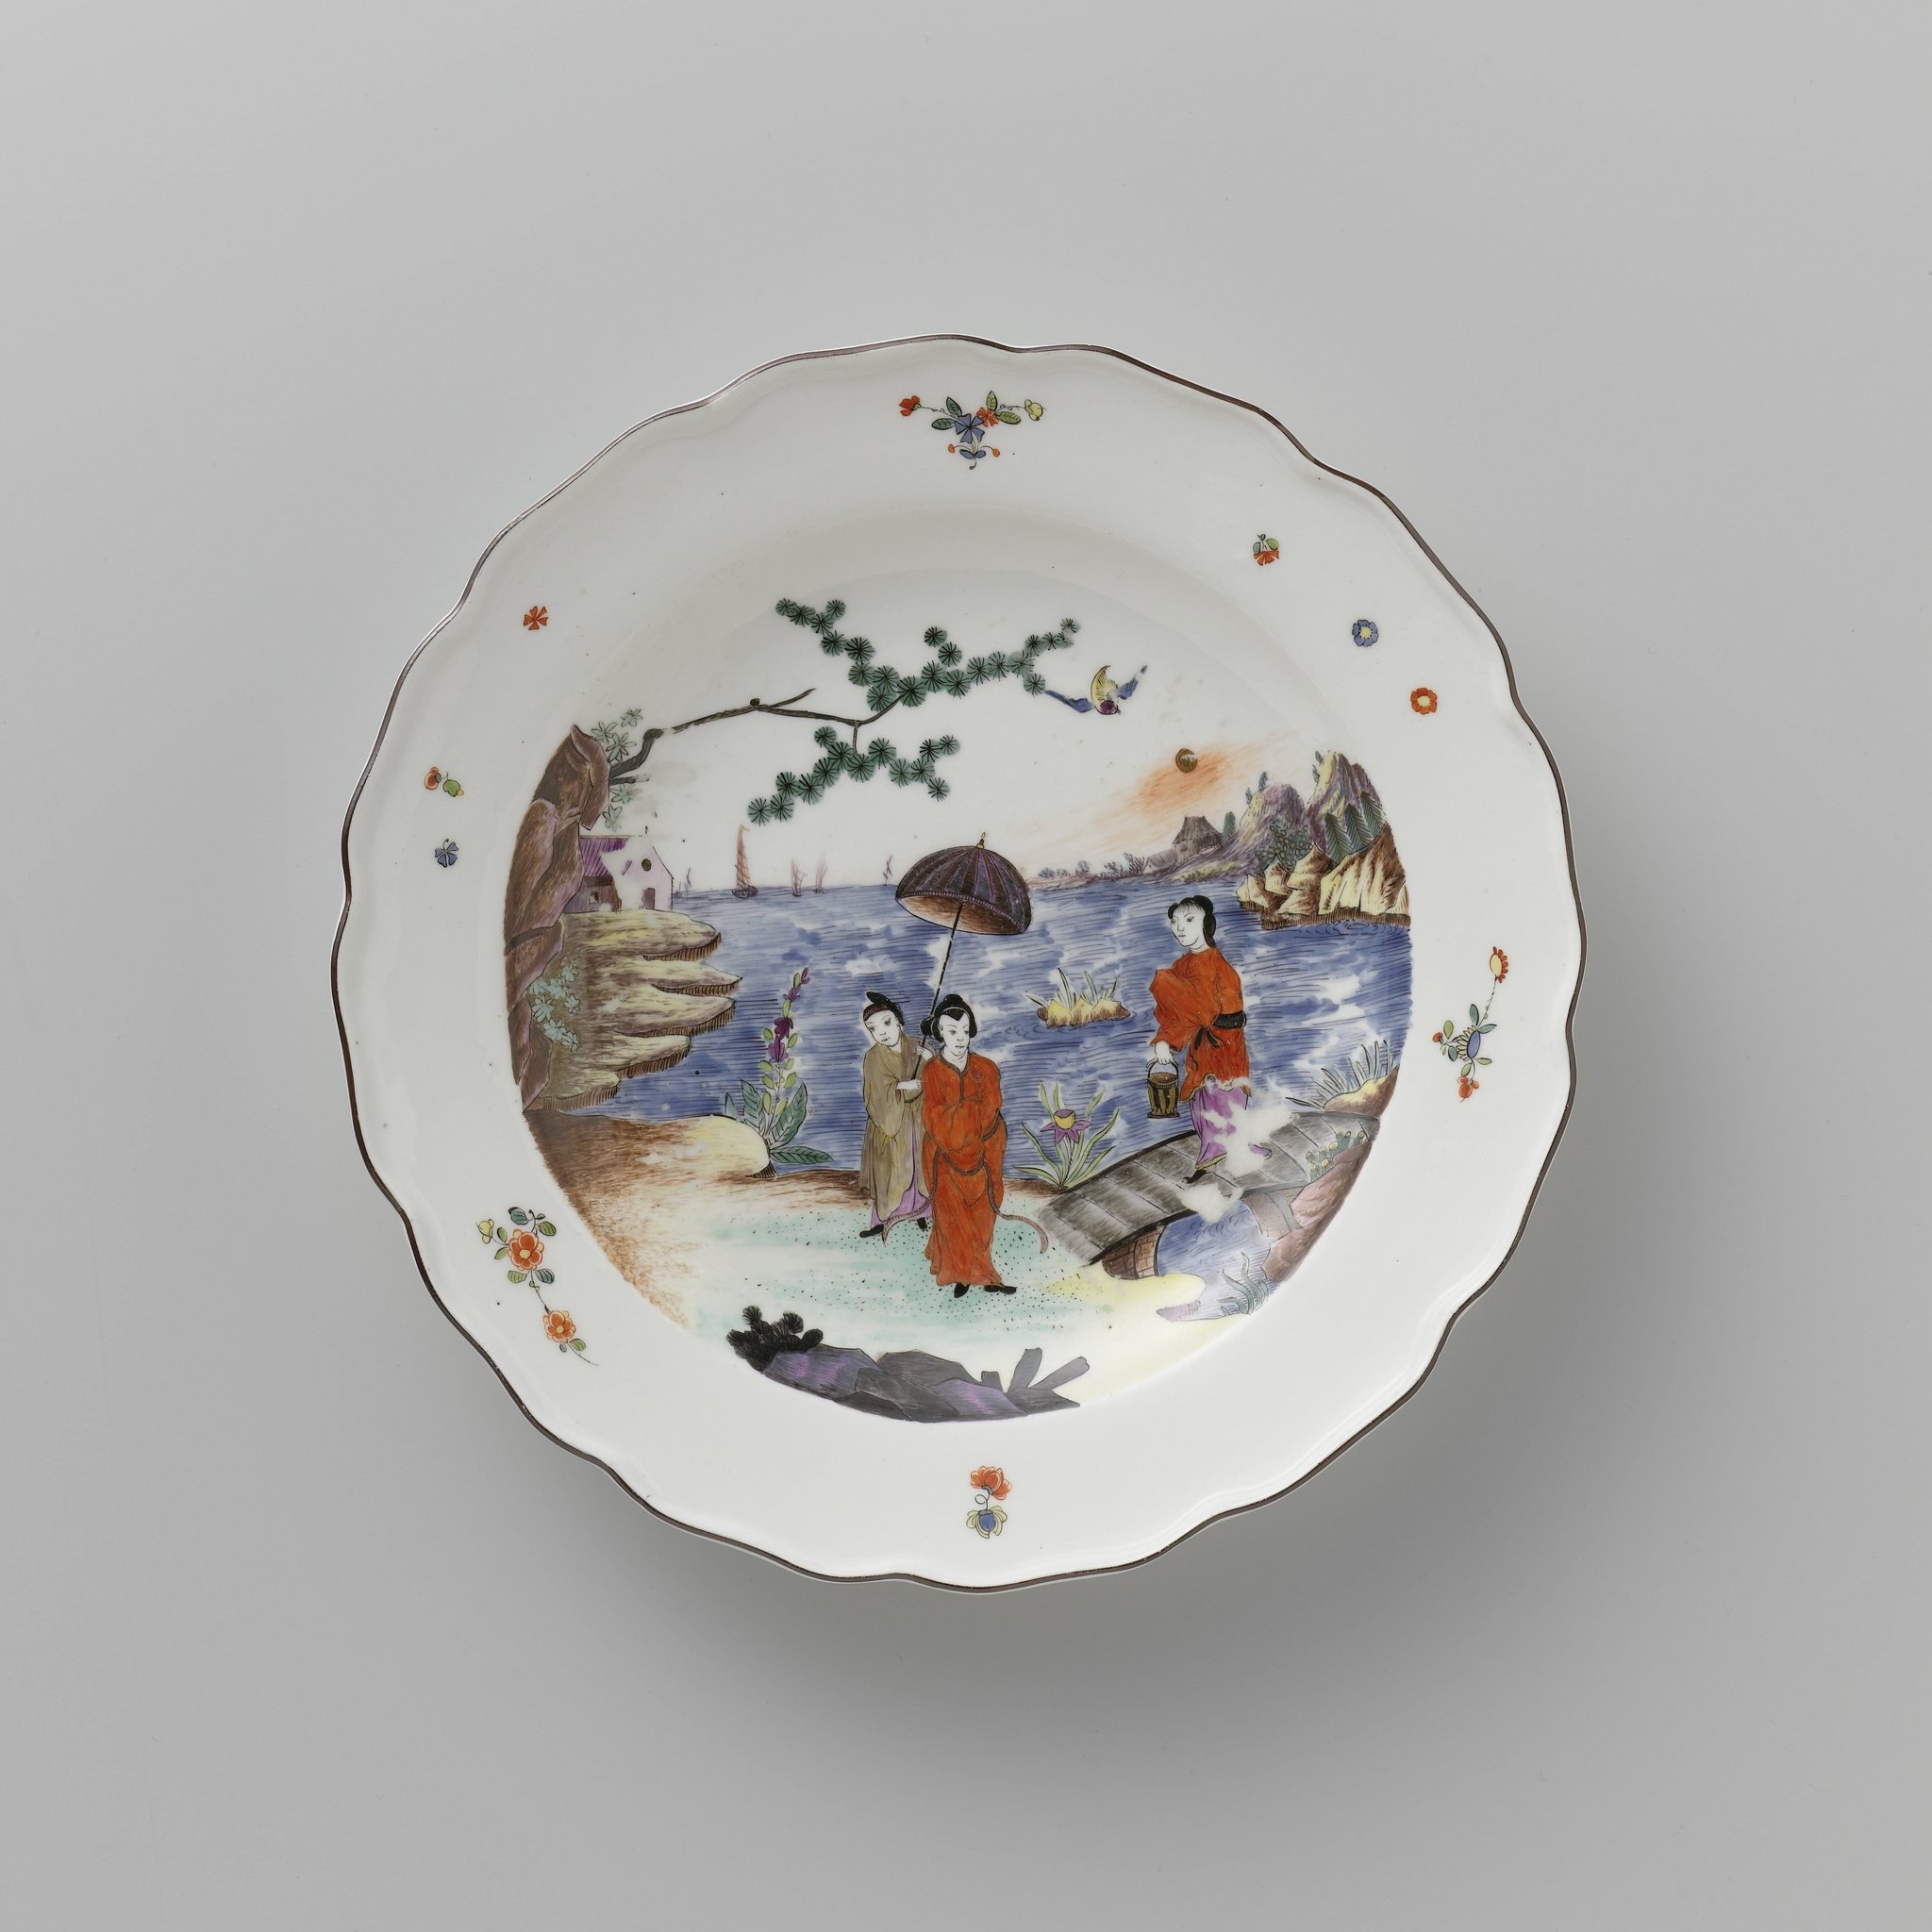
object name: plate dish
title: Eleven dinner plates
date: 1735-1740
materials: porcelain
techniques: painted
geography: meissen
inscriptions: factory mark, mold mark: ‘16’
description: Meissener Porzellan Manufaktur Meissen, c. 1735–1740 after prints by Petrus Schenk (1693–1775) hard-paste porcelain